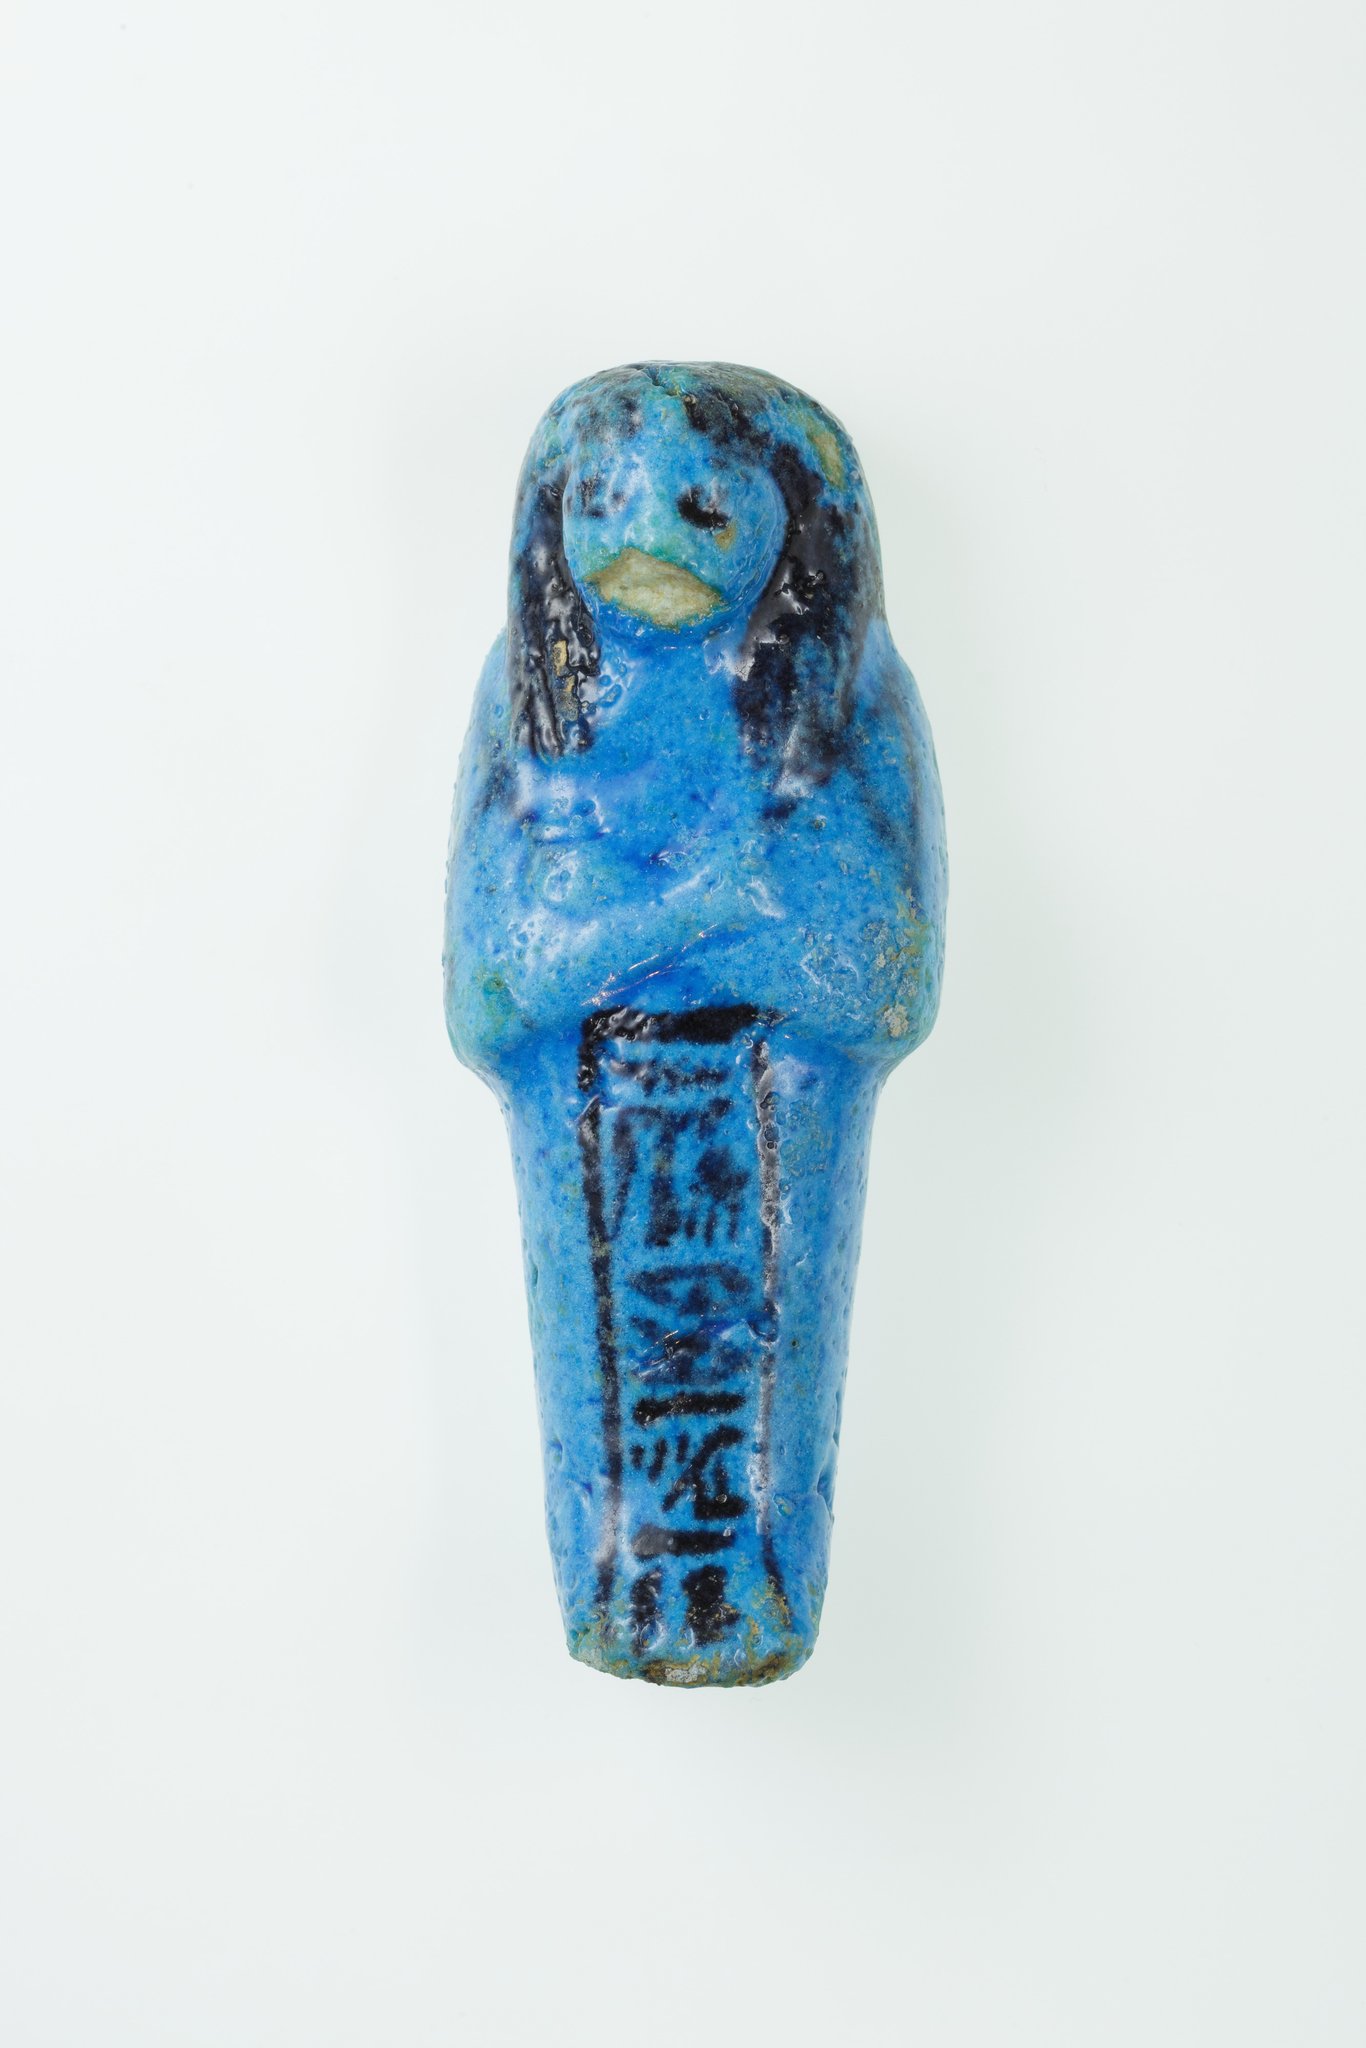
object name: shabti, worker, nauny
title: Worker Shabti of Nauny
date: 1050 BCE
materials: faience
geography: egypt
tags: hieroglyphs